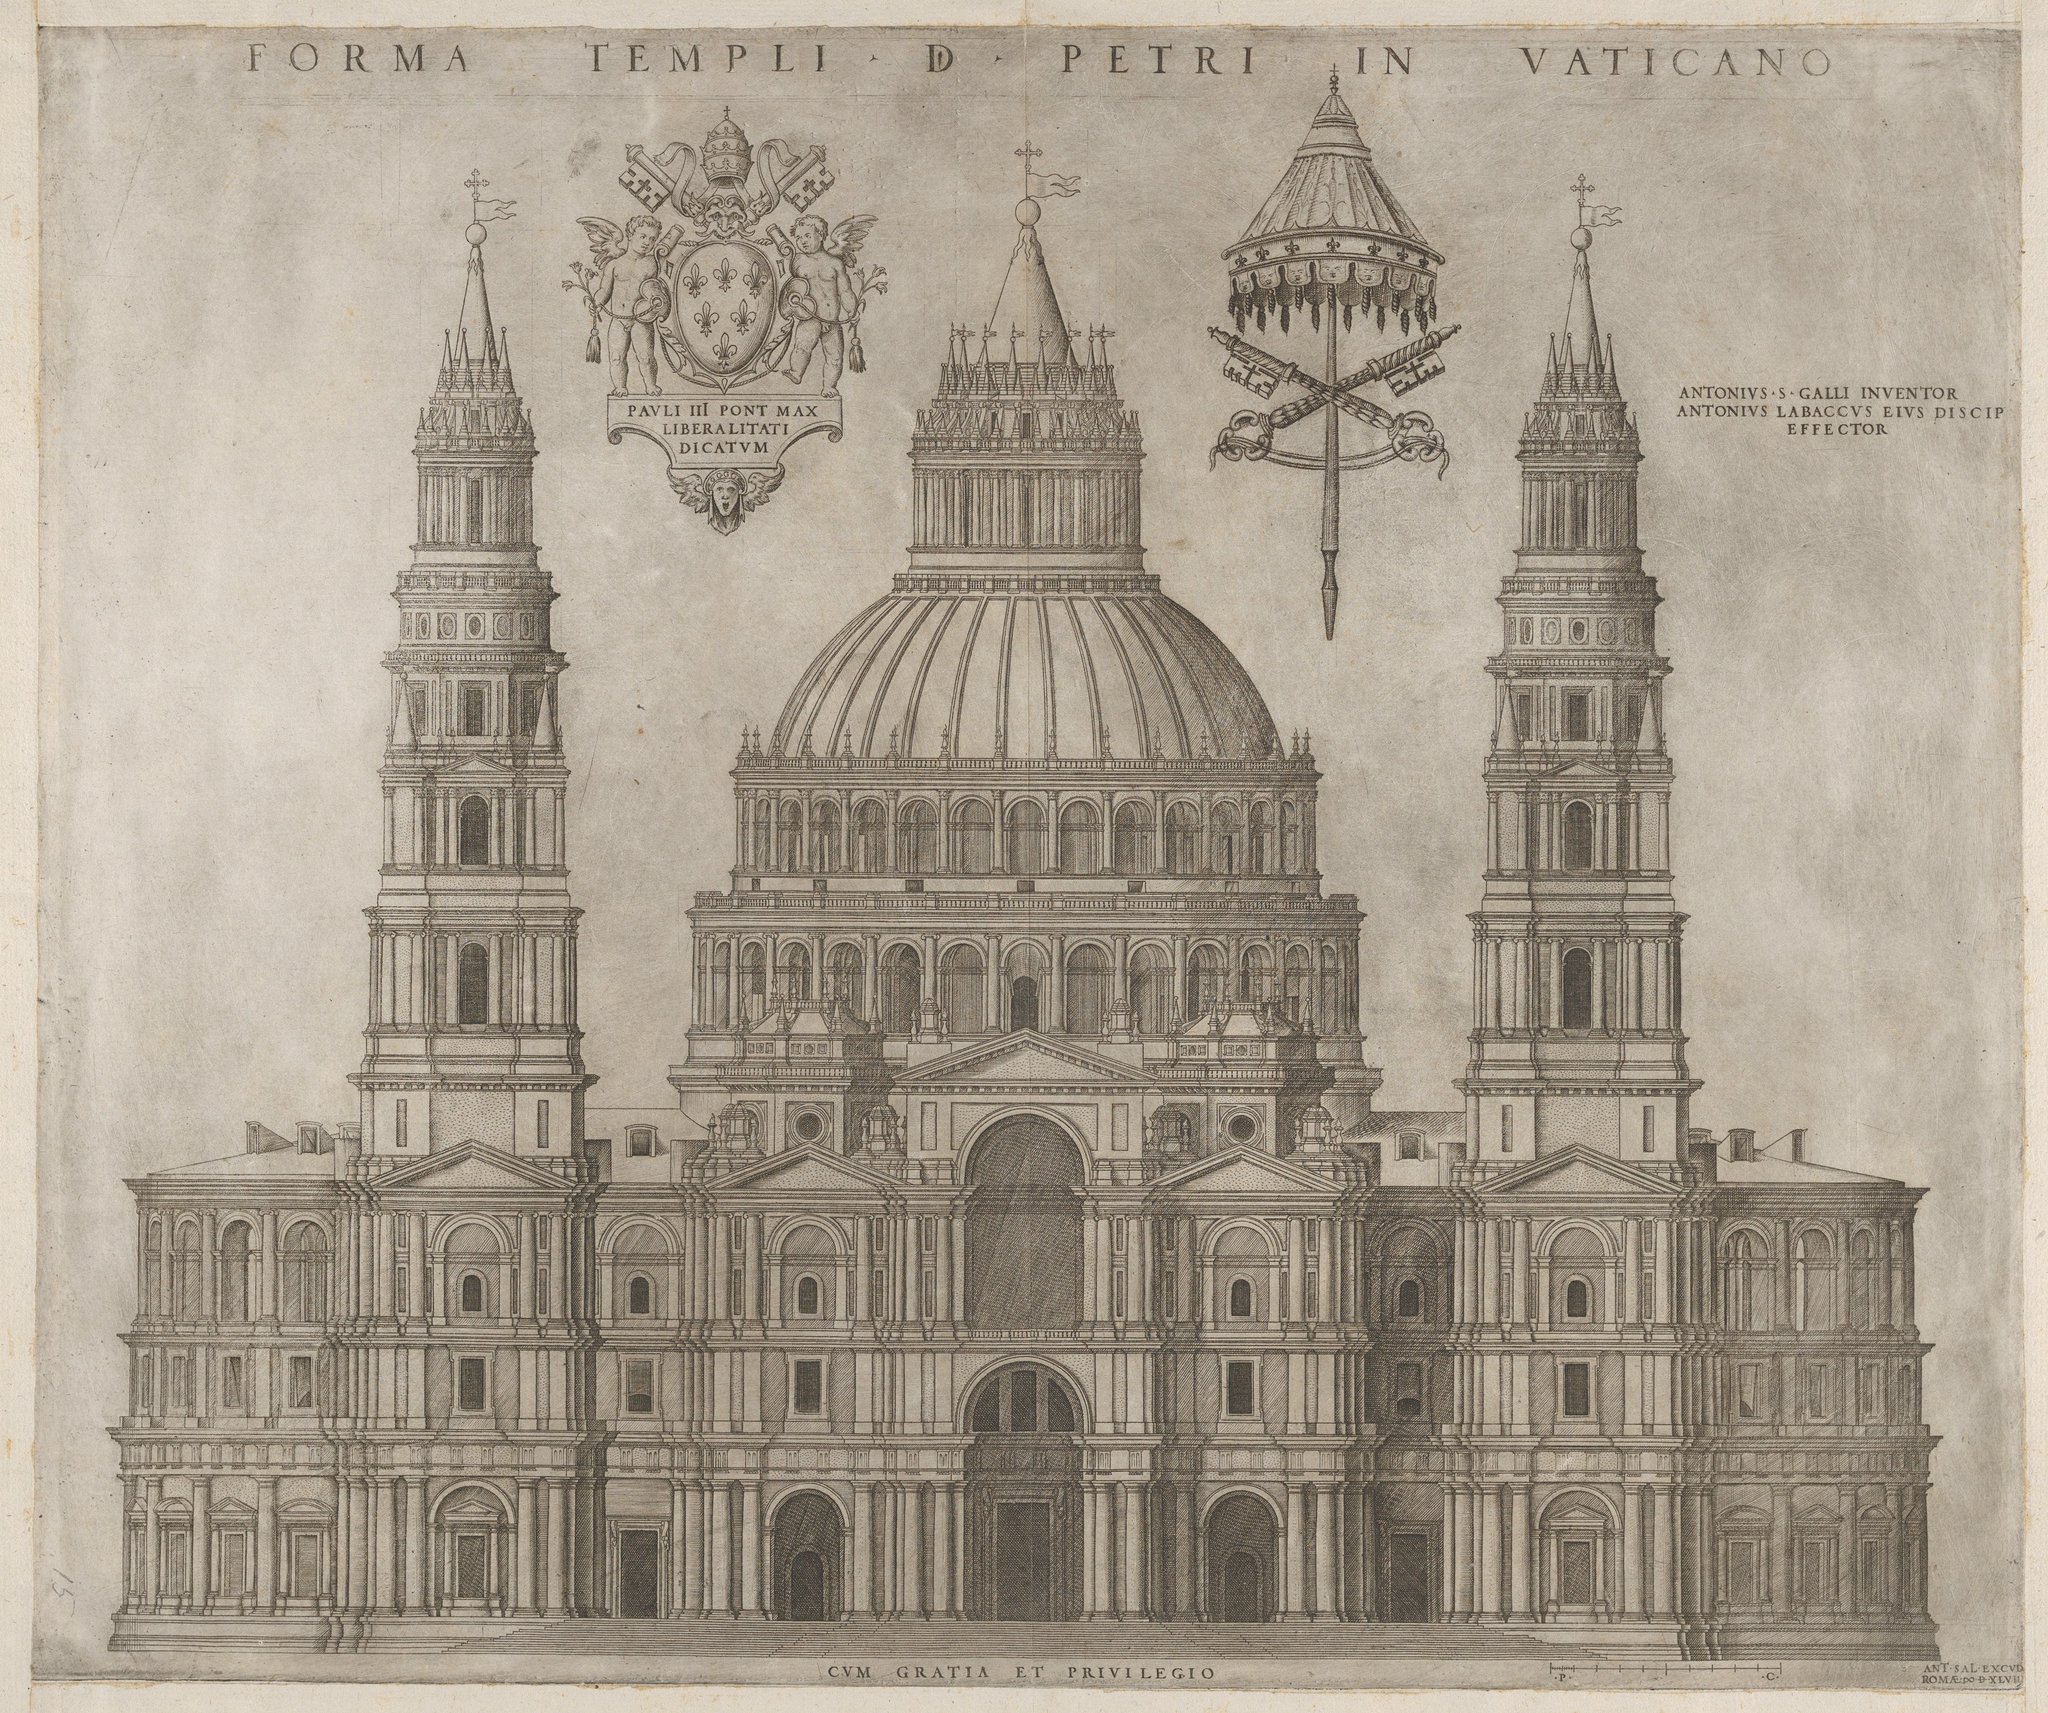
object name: print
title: St. Peter's, from "Speculum Romanae Magnificentiae"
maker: antonio da sangallo, the younger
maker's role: artist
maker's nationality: italian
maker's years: 1484-1546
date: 1547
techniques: engraving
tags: architecture,churches,coat of arms,rome